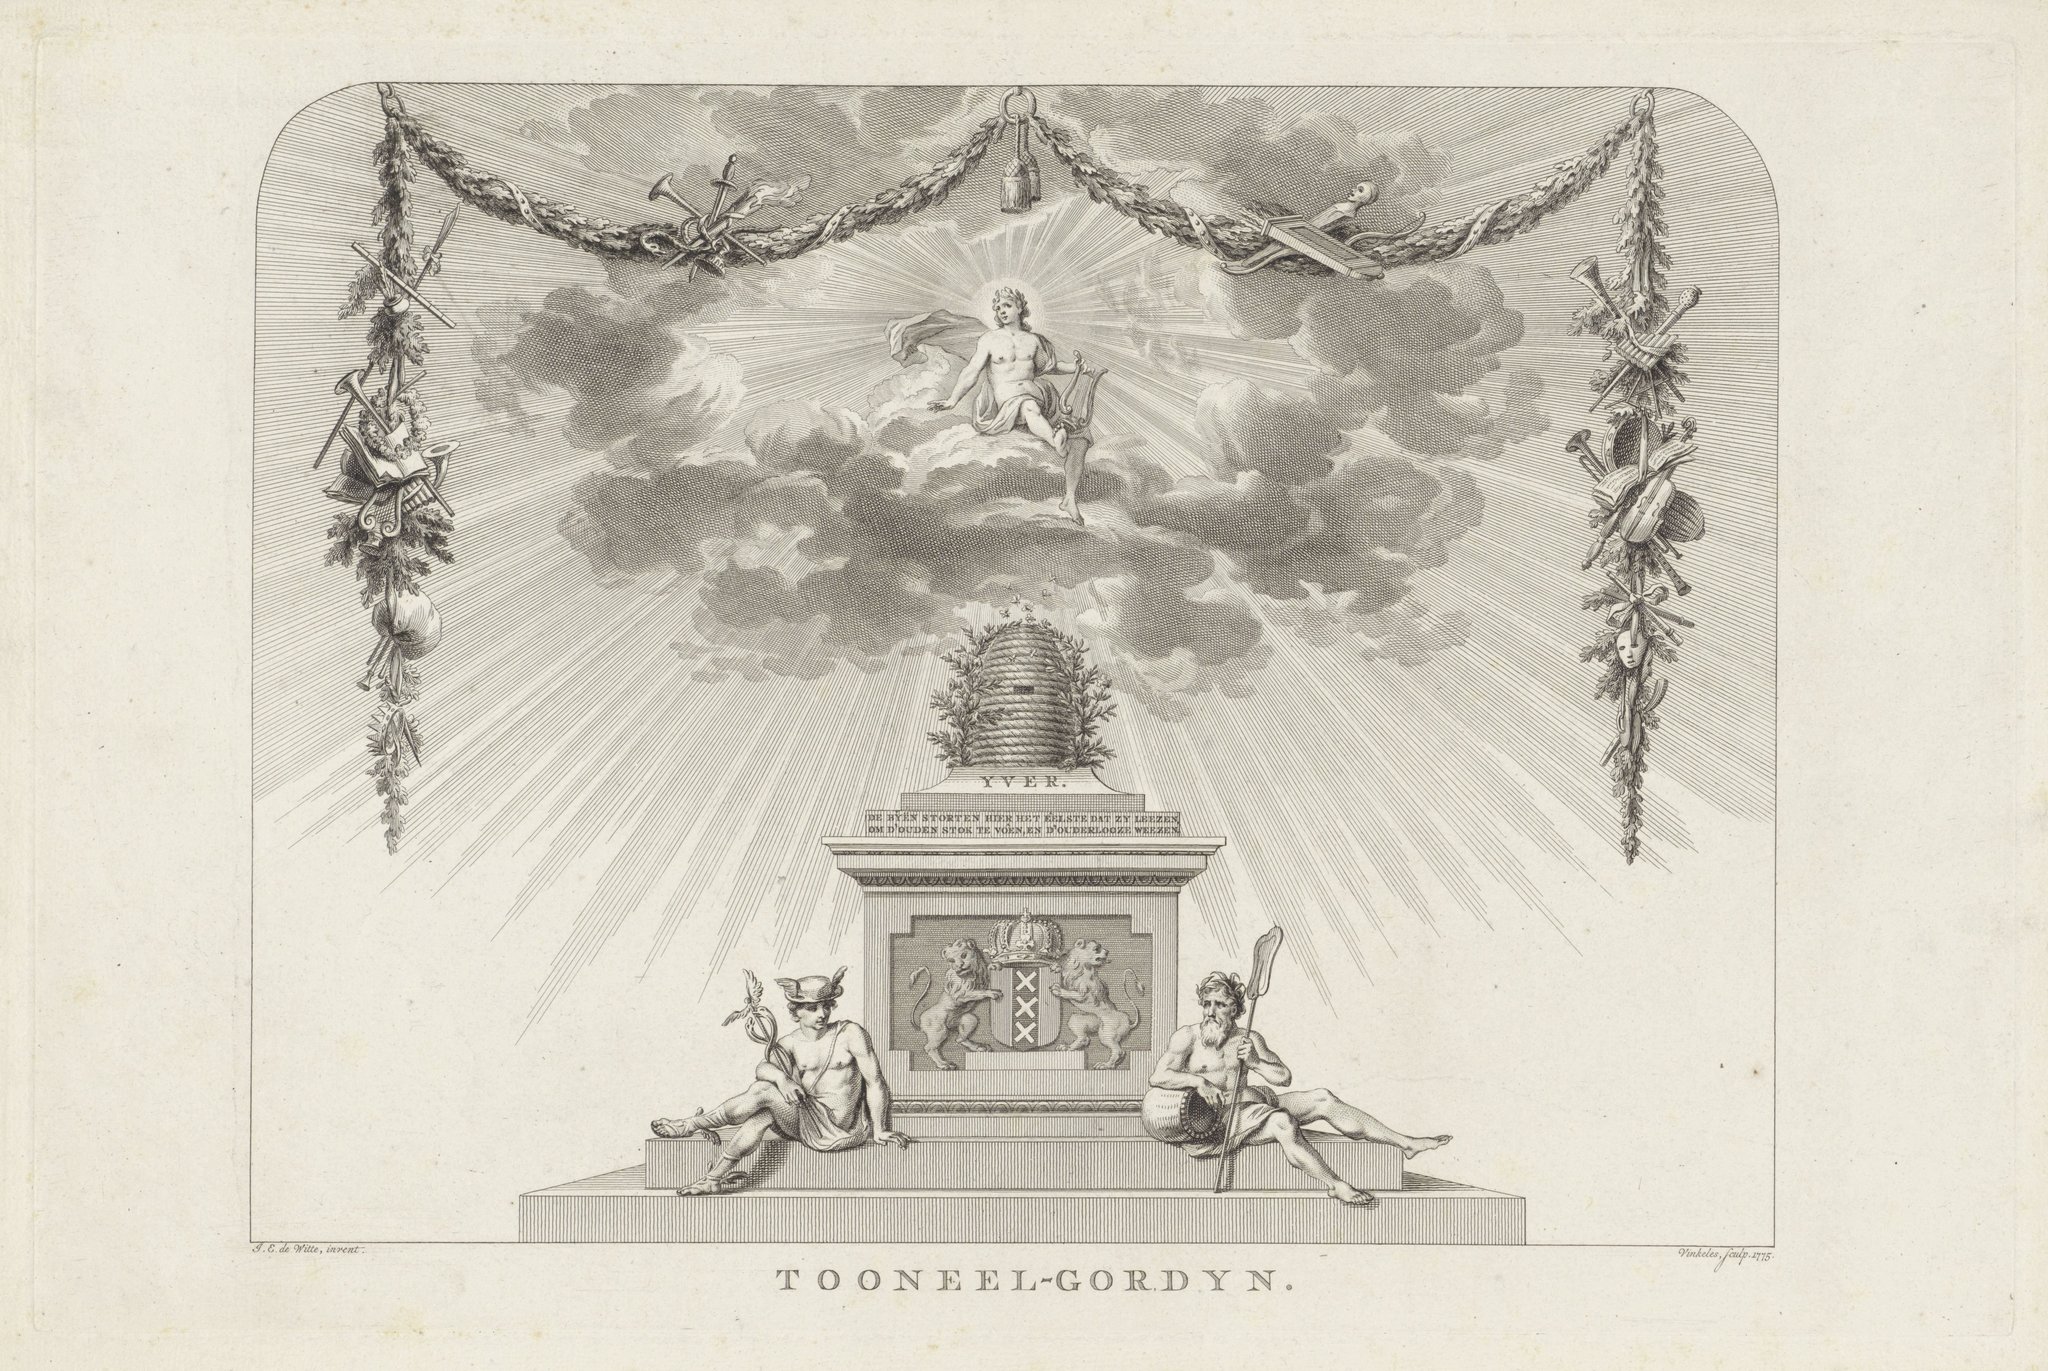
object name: print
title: Afbeeldingen van den Schouwburg te Amsterdam (...) MDCCLXXIV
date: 1775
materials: paper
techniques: engraving, etching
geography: amsterdam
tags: symbolic representations, allegories and emblems ~ the theatre, (story of) apollo (phoebus), (story of) mercury (hermes), theatre (building), bee-hive, amsterdam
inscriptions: collector's mark: Lugt 2228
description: Apollo met lier zit op een wolkendek, met om zijn hoofd een stralenkrans. Onder hem een bijenkorf met het woord 'IJver' op een sokkel, die geflankeerd wordt door links Mercurius en rechts een riviergod. Op de sokkel het stadswapen van Amsterdam. Bovenaan een guirlande met toneelattributen en muziekinstrumenten.